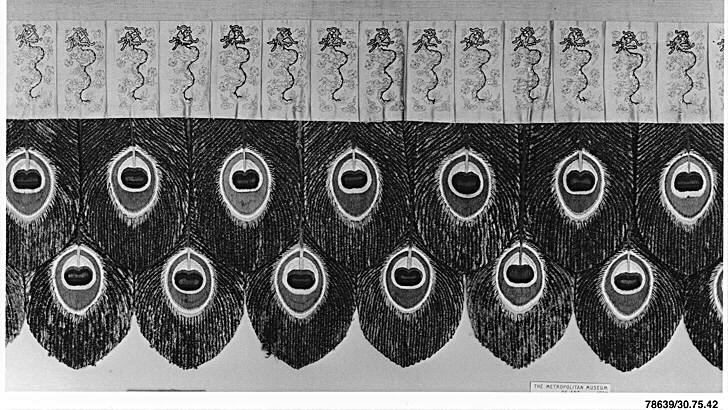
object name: valance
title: Section of a Valance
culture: chinese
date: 1701-1800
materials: feather, metal thread, silk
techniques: embroidery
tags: feathers